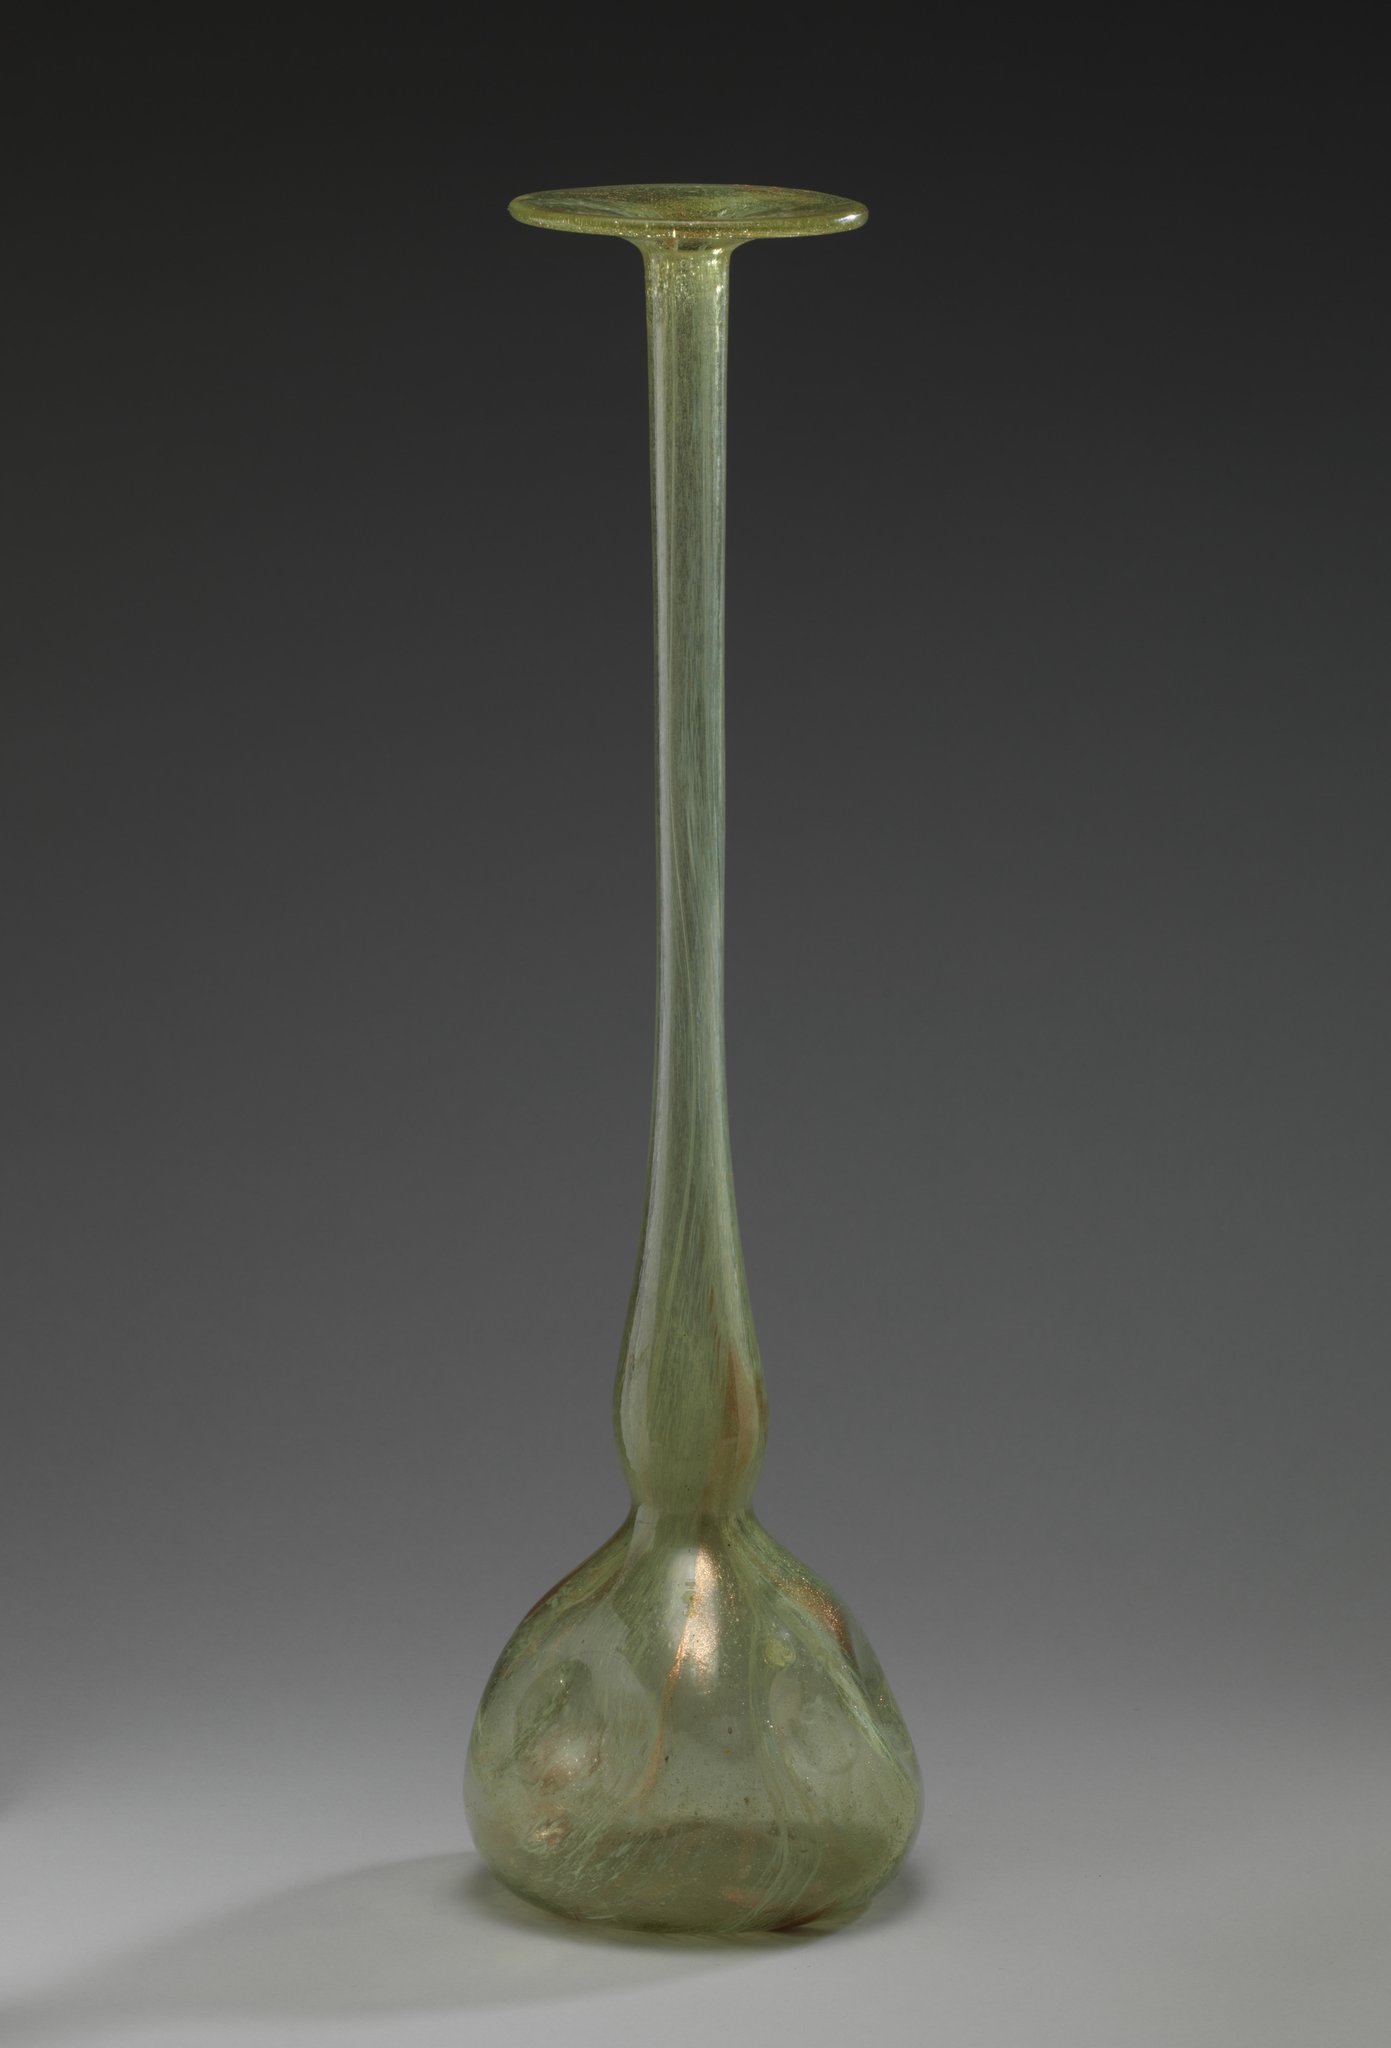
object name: vase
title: Clutha vase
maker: christopher dresser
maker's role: designer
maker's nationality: british, scottish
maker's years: 1834-1904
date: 1895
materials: glass